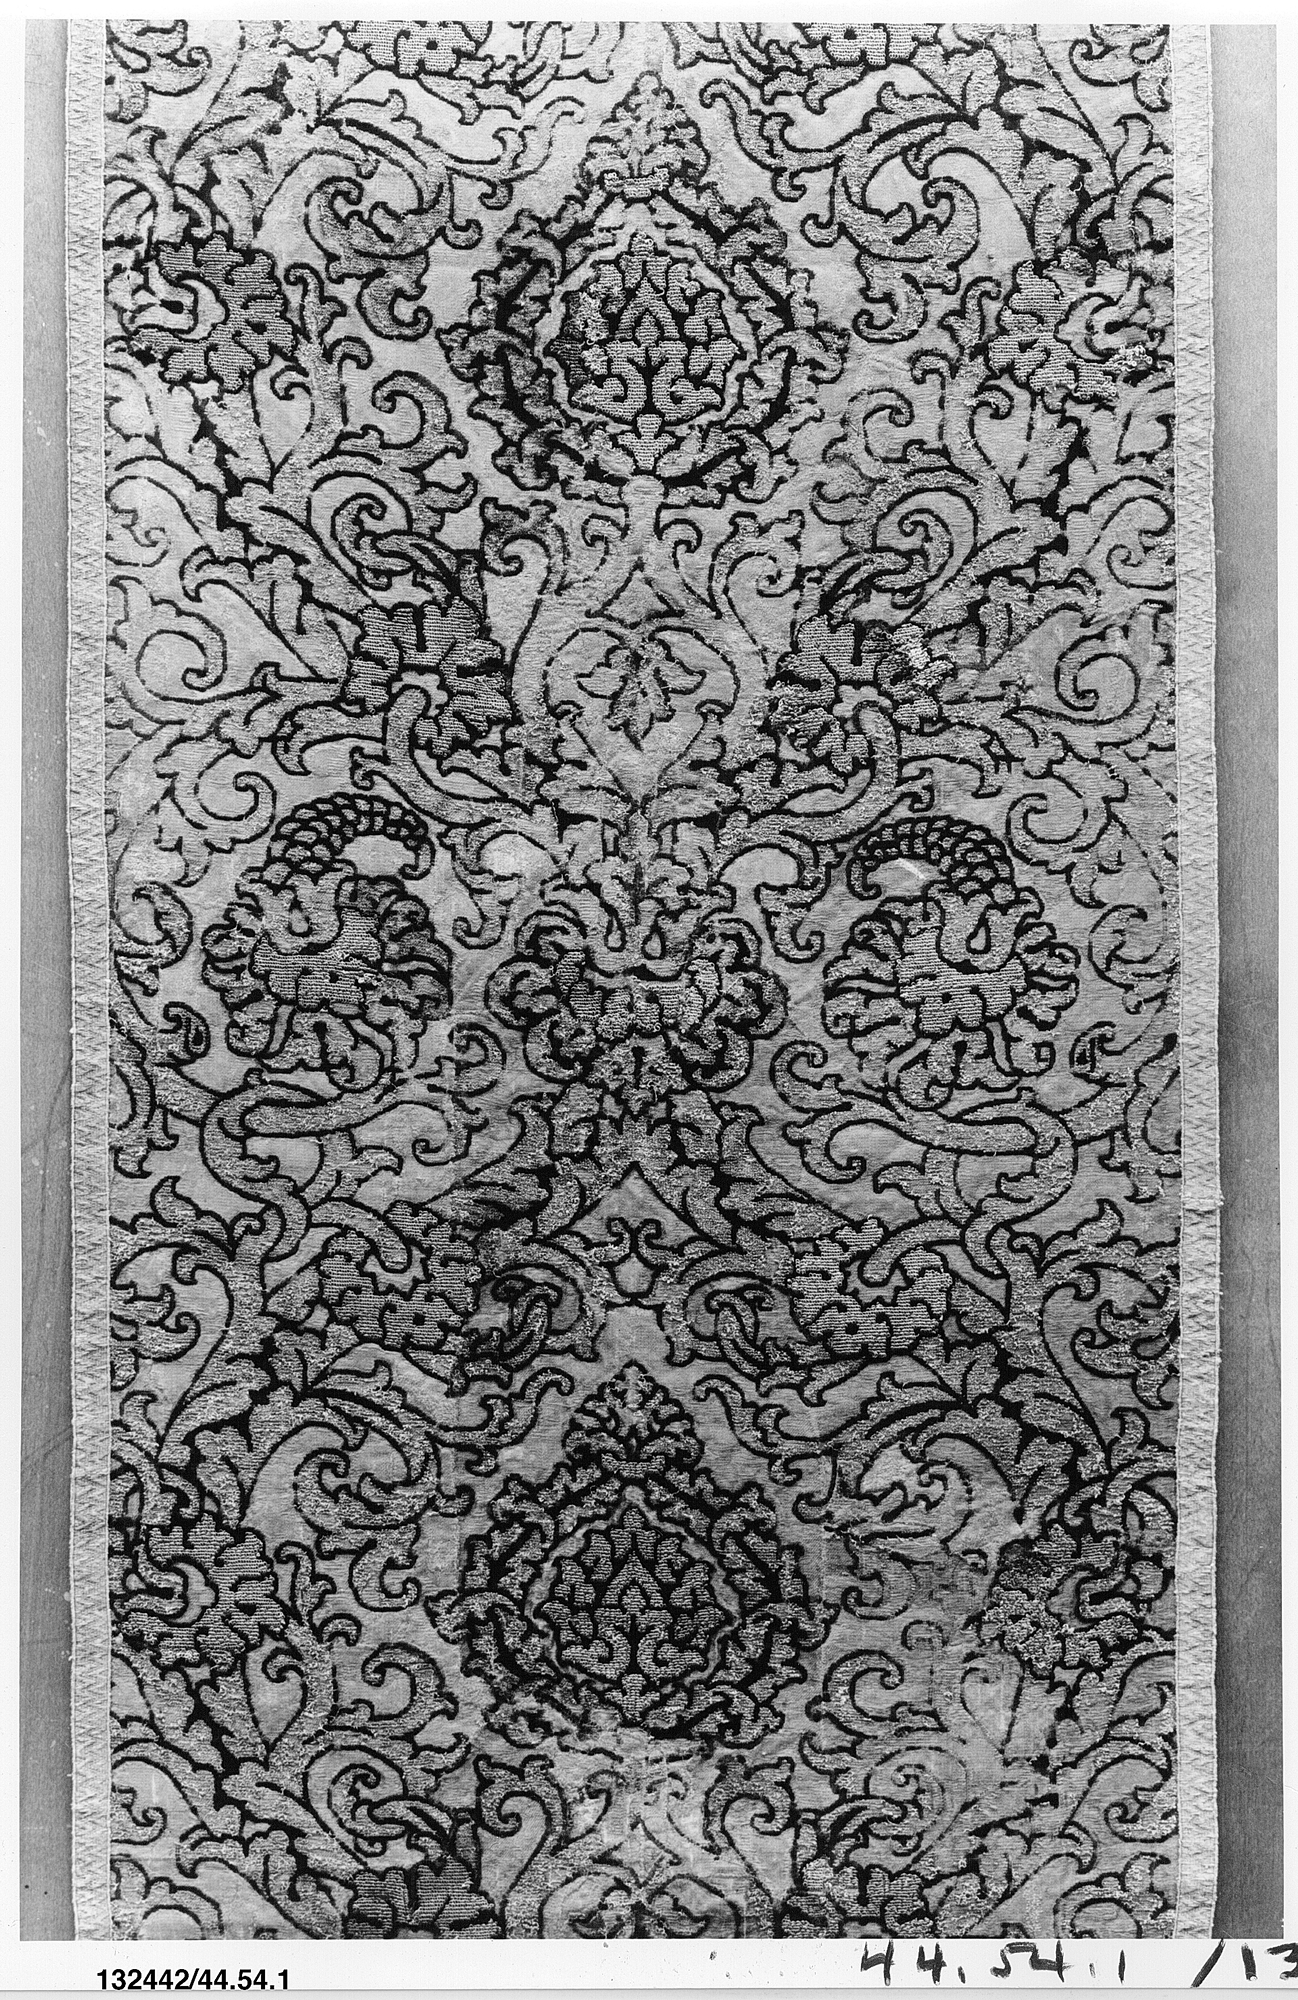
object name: length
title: Panel of velvet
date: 1551-1600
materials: metal thread, silk